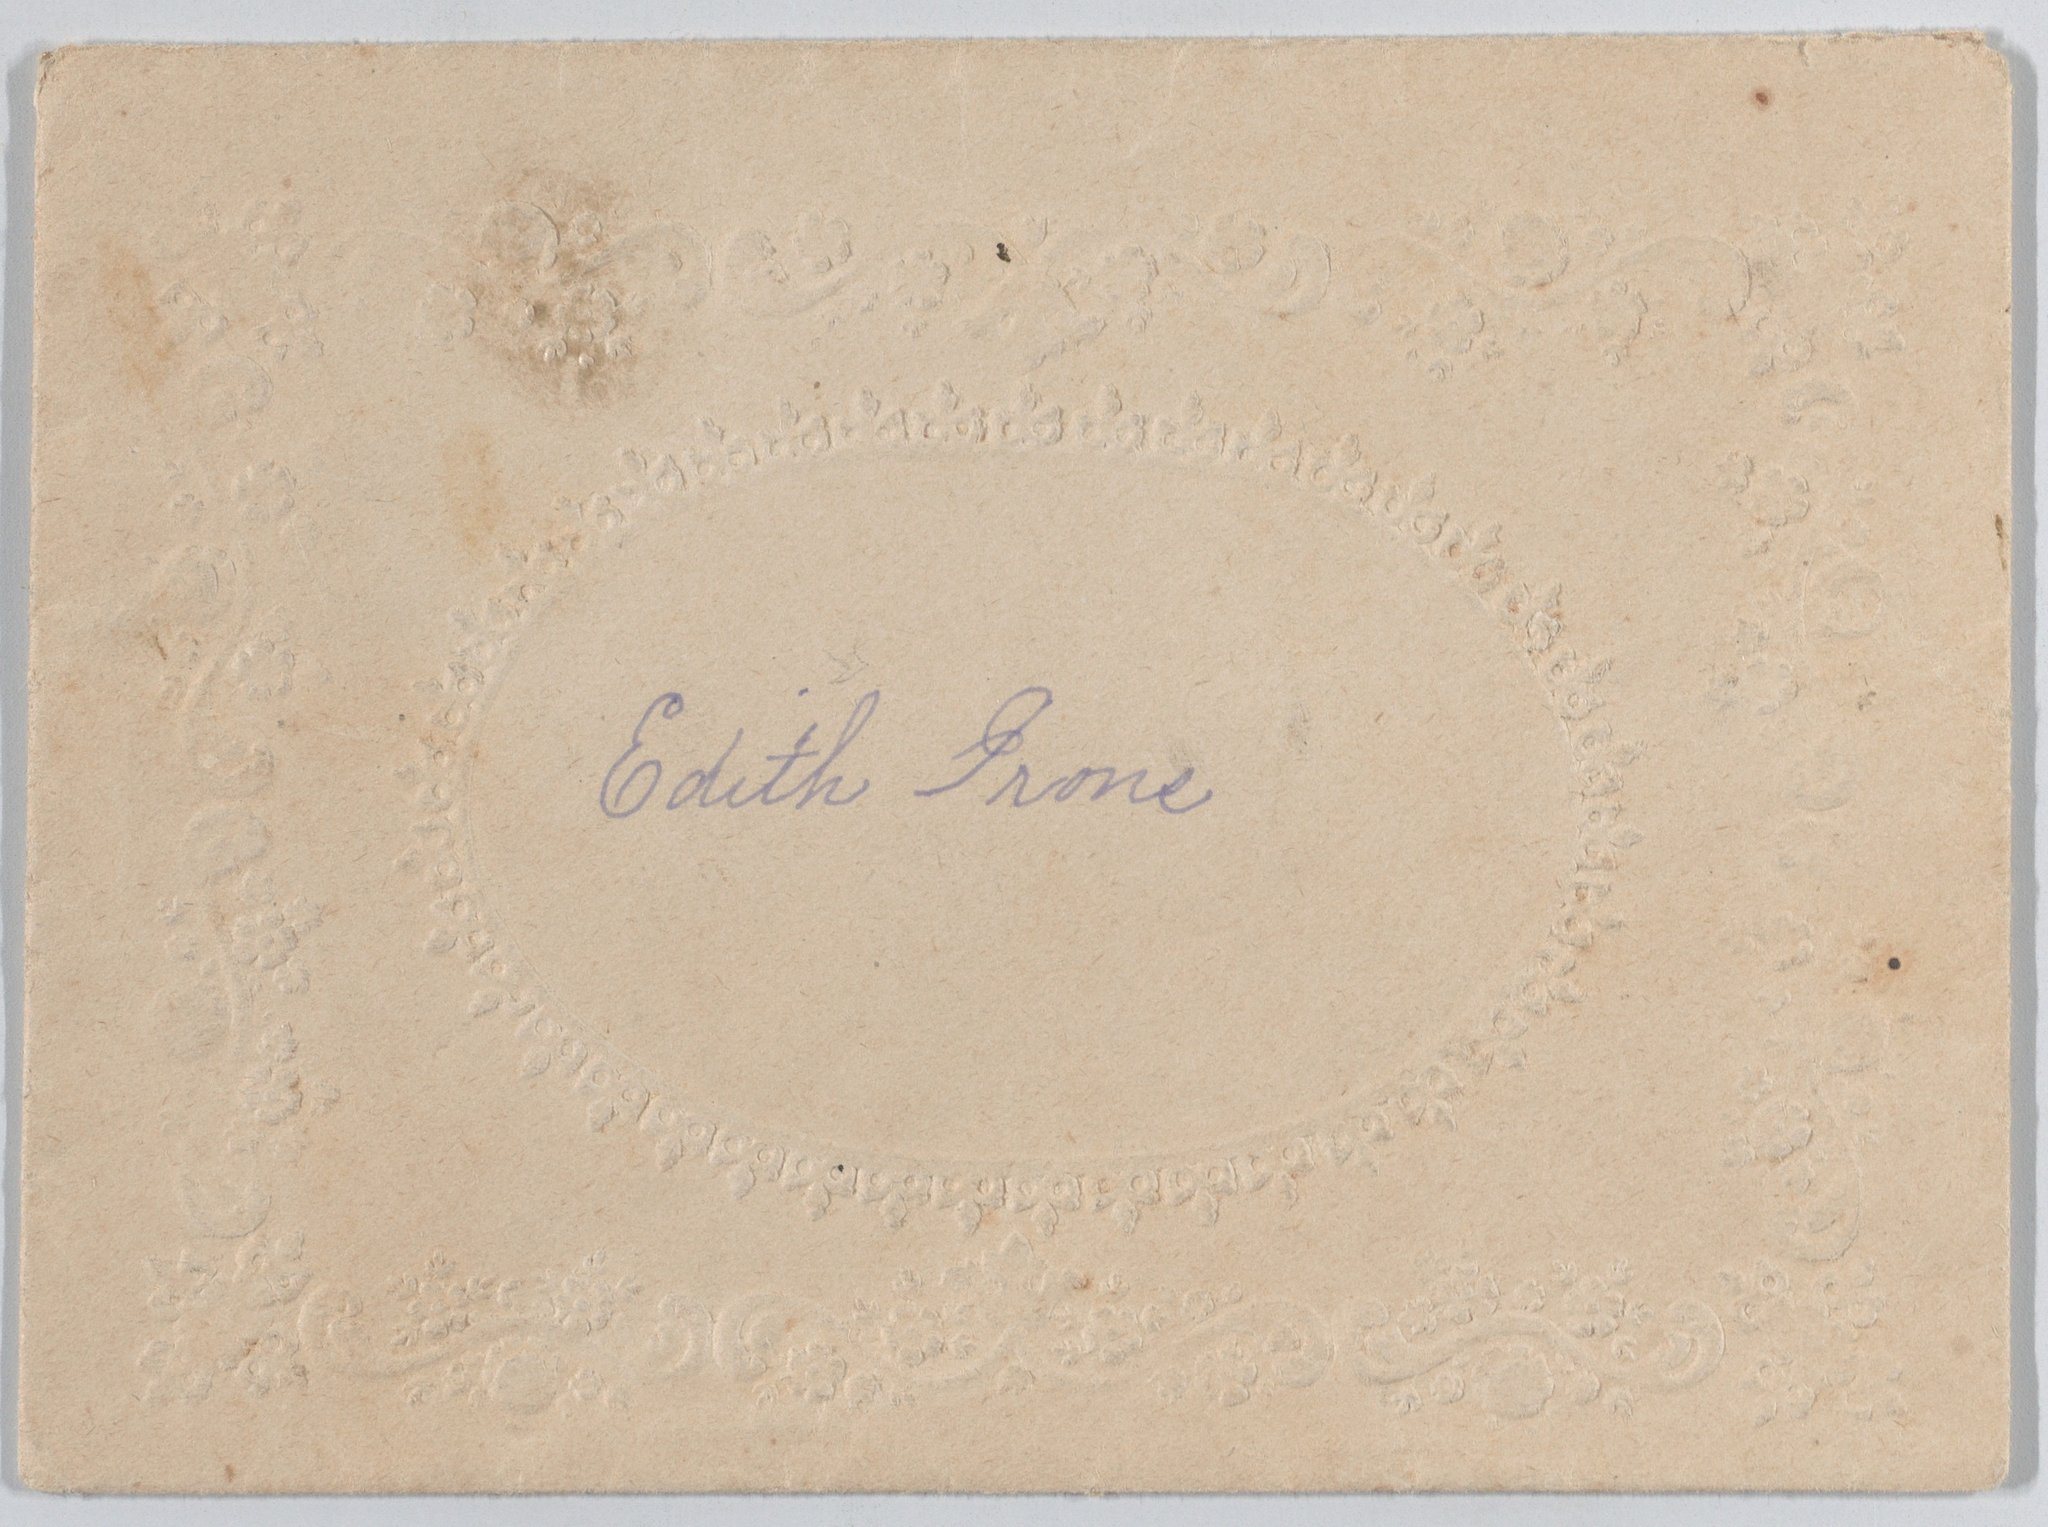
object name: valentine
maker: Anonymous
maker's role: artist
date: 1850-1870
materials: ink, lace, paper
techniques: chromolithography, embossing, open work